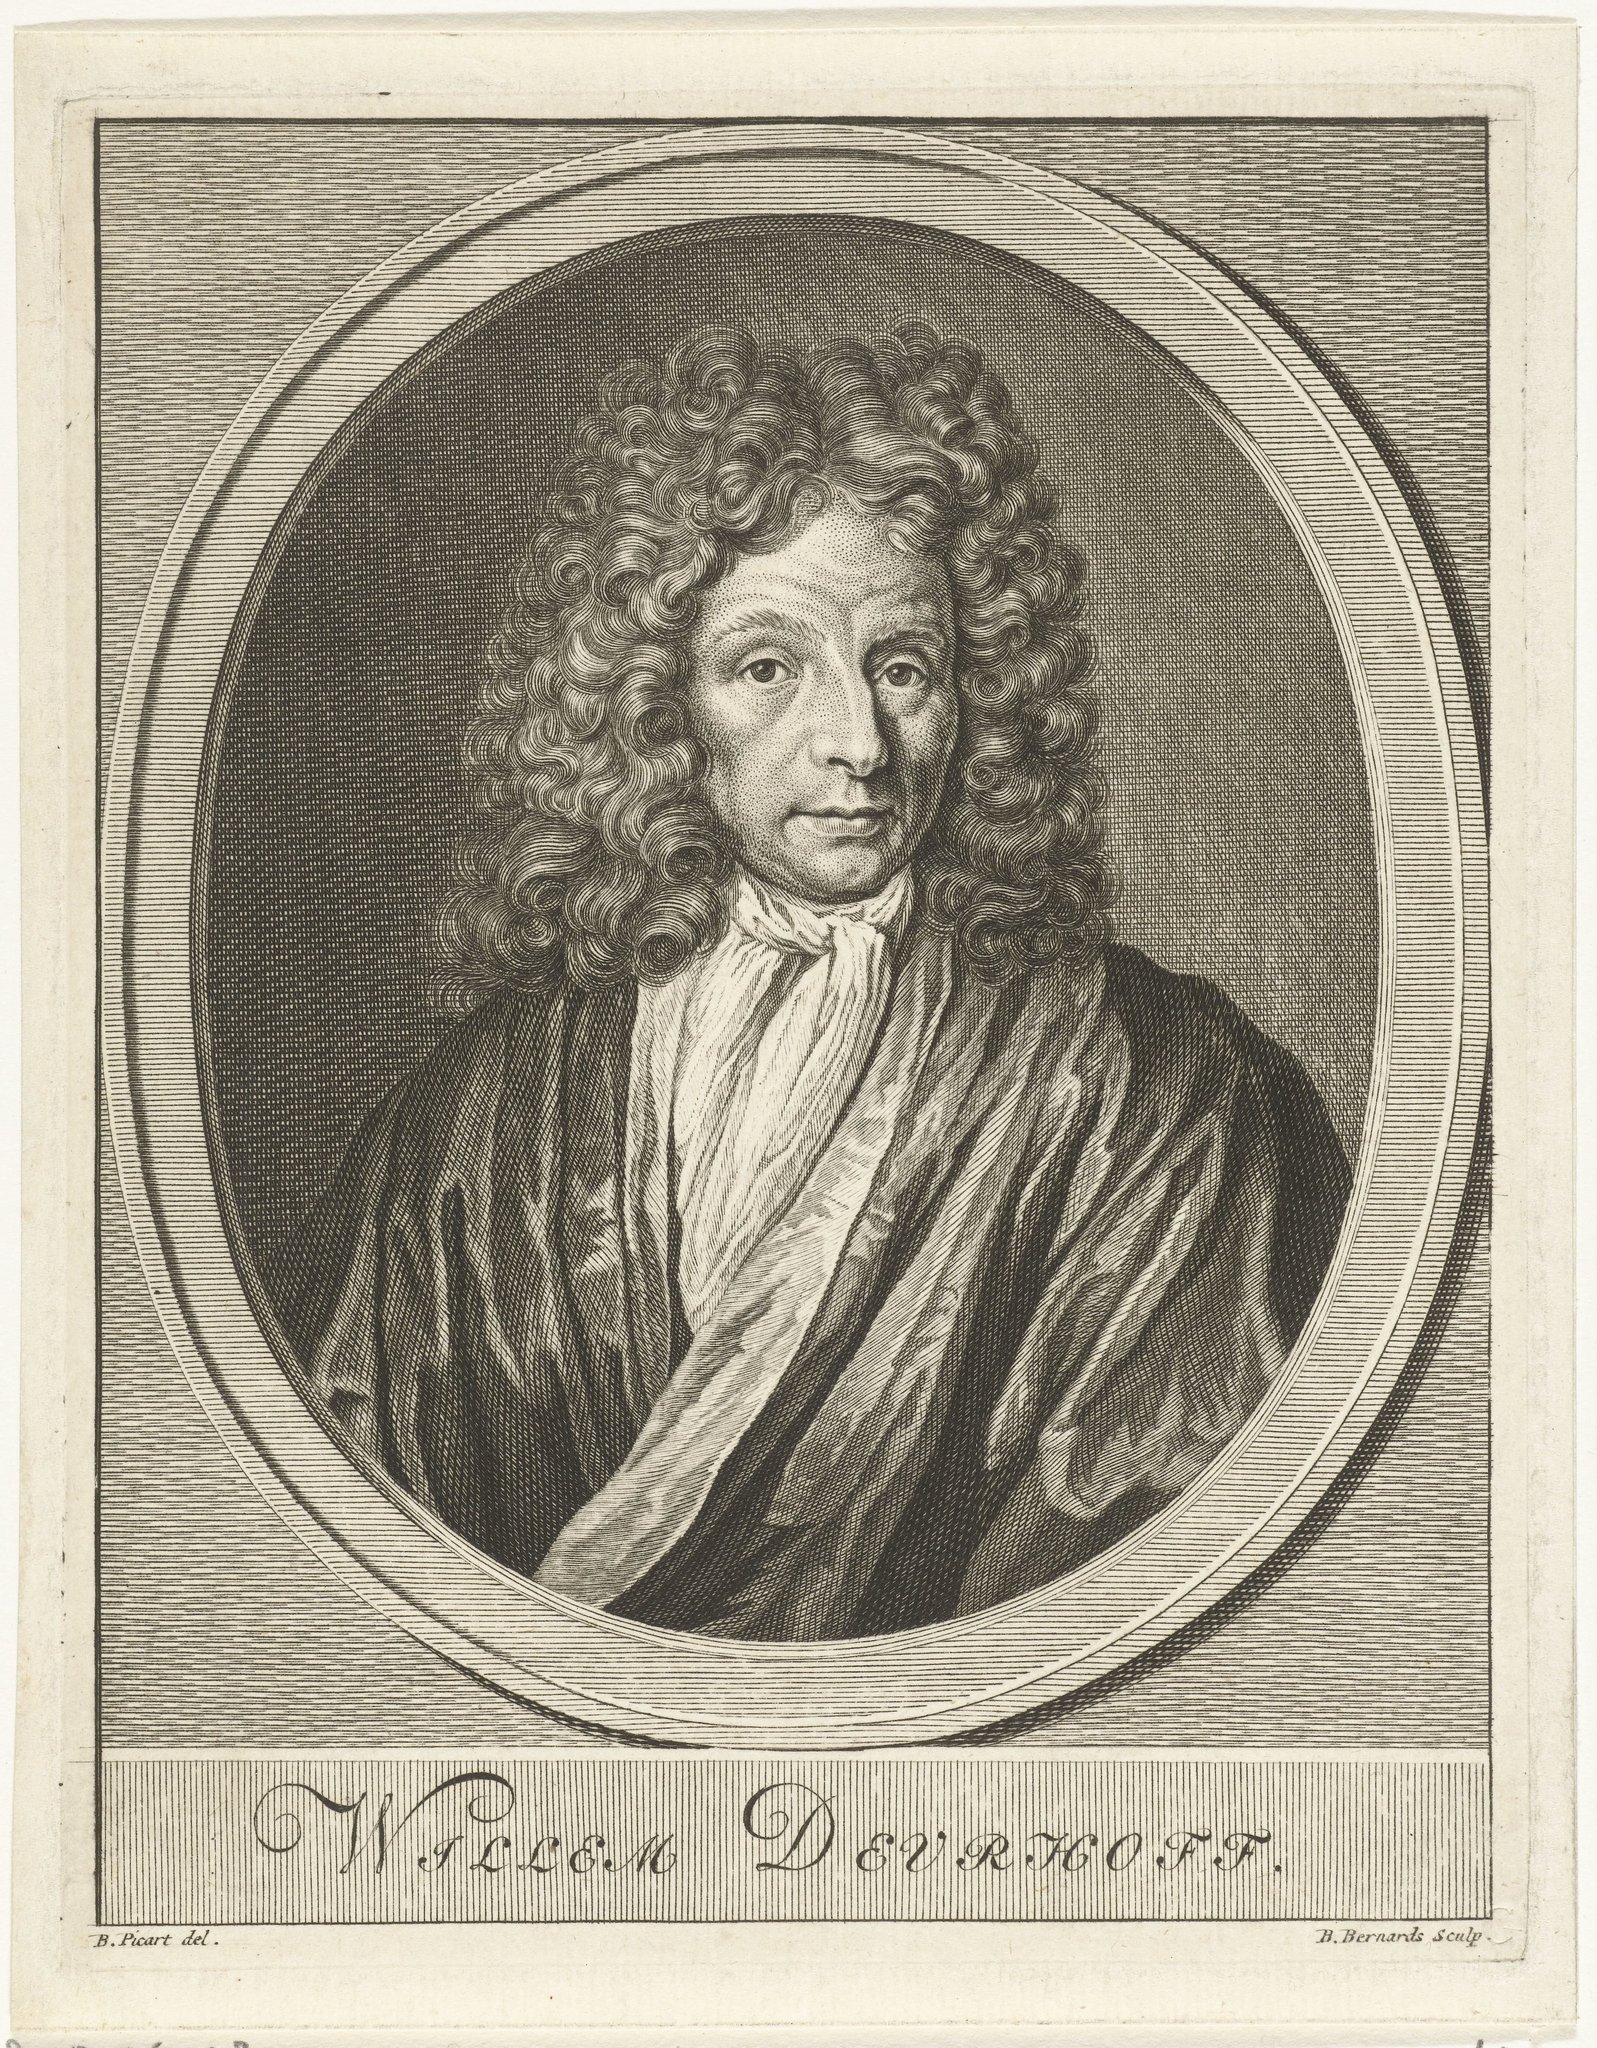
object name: print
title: Portret van Willem Deurhof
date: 1711-1737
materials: paper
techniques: engraving, etching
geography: amsterdam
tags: schrijver, willem deurhoff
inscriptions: collector's mark: Lugt 2228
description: Borstbeeld van Willem Deurhof in ovaal. Onder het portret zijn naam.